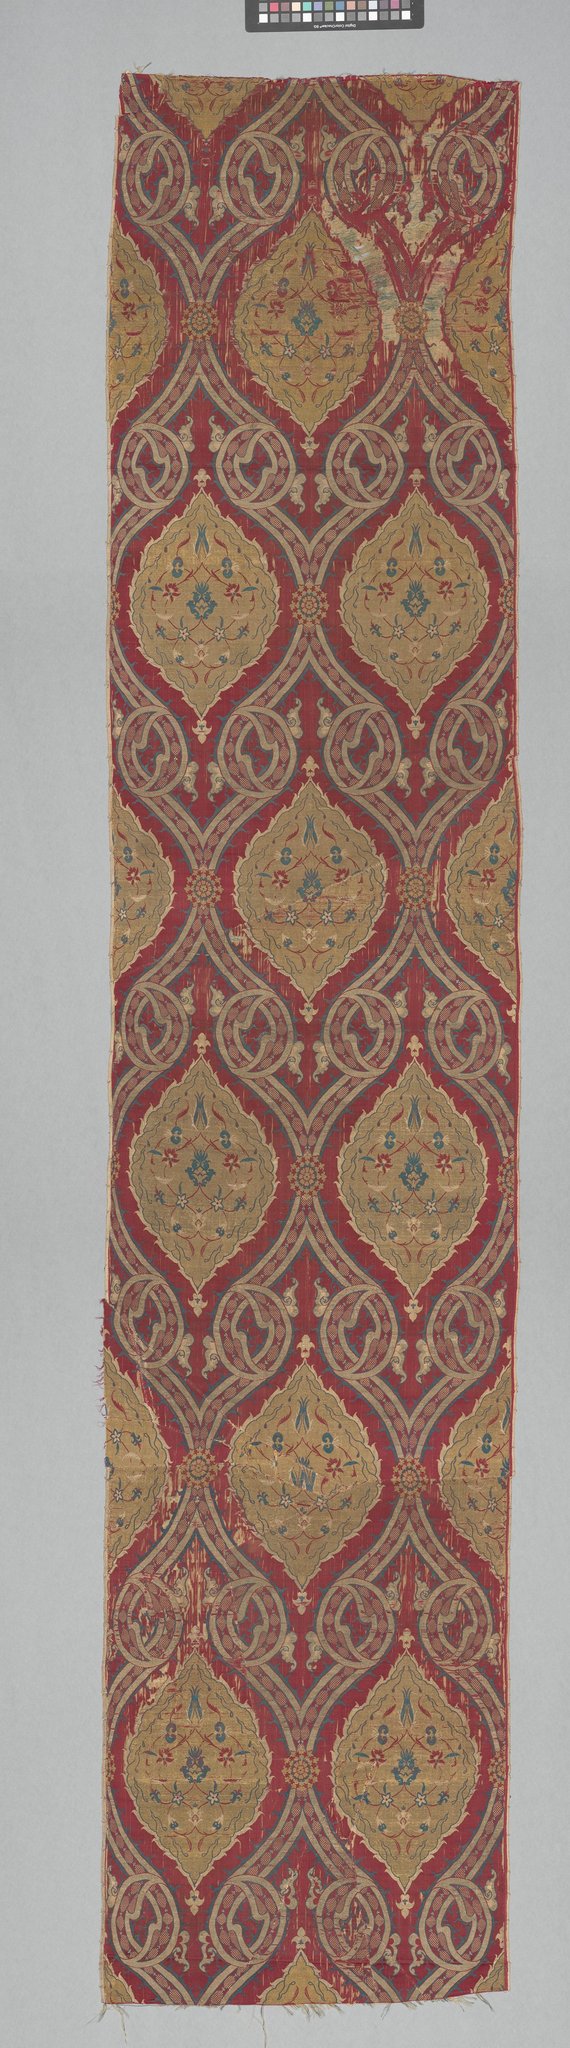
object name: textile fragment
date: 1570-1580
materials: metal thread, silk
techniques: lampas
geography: turkey